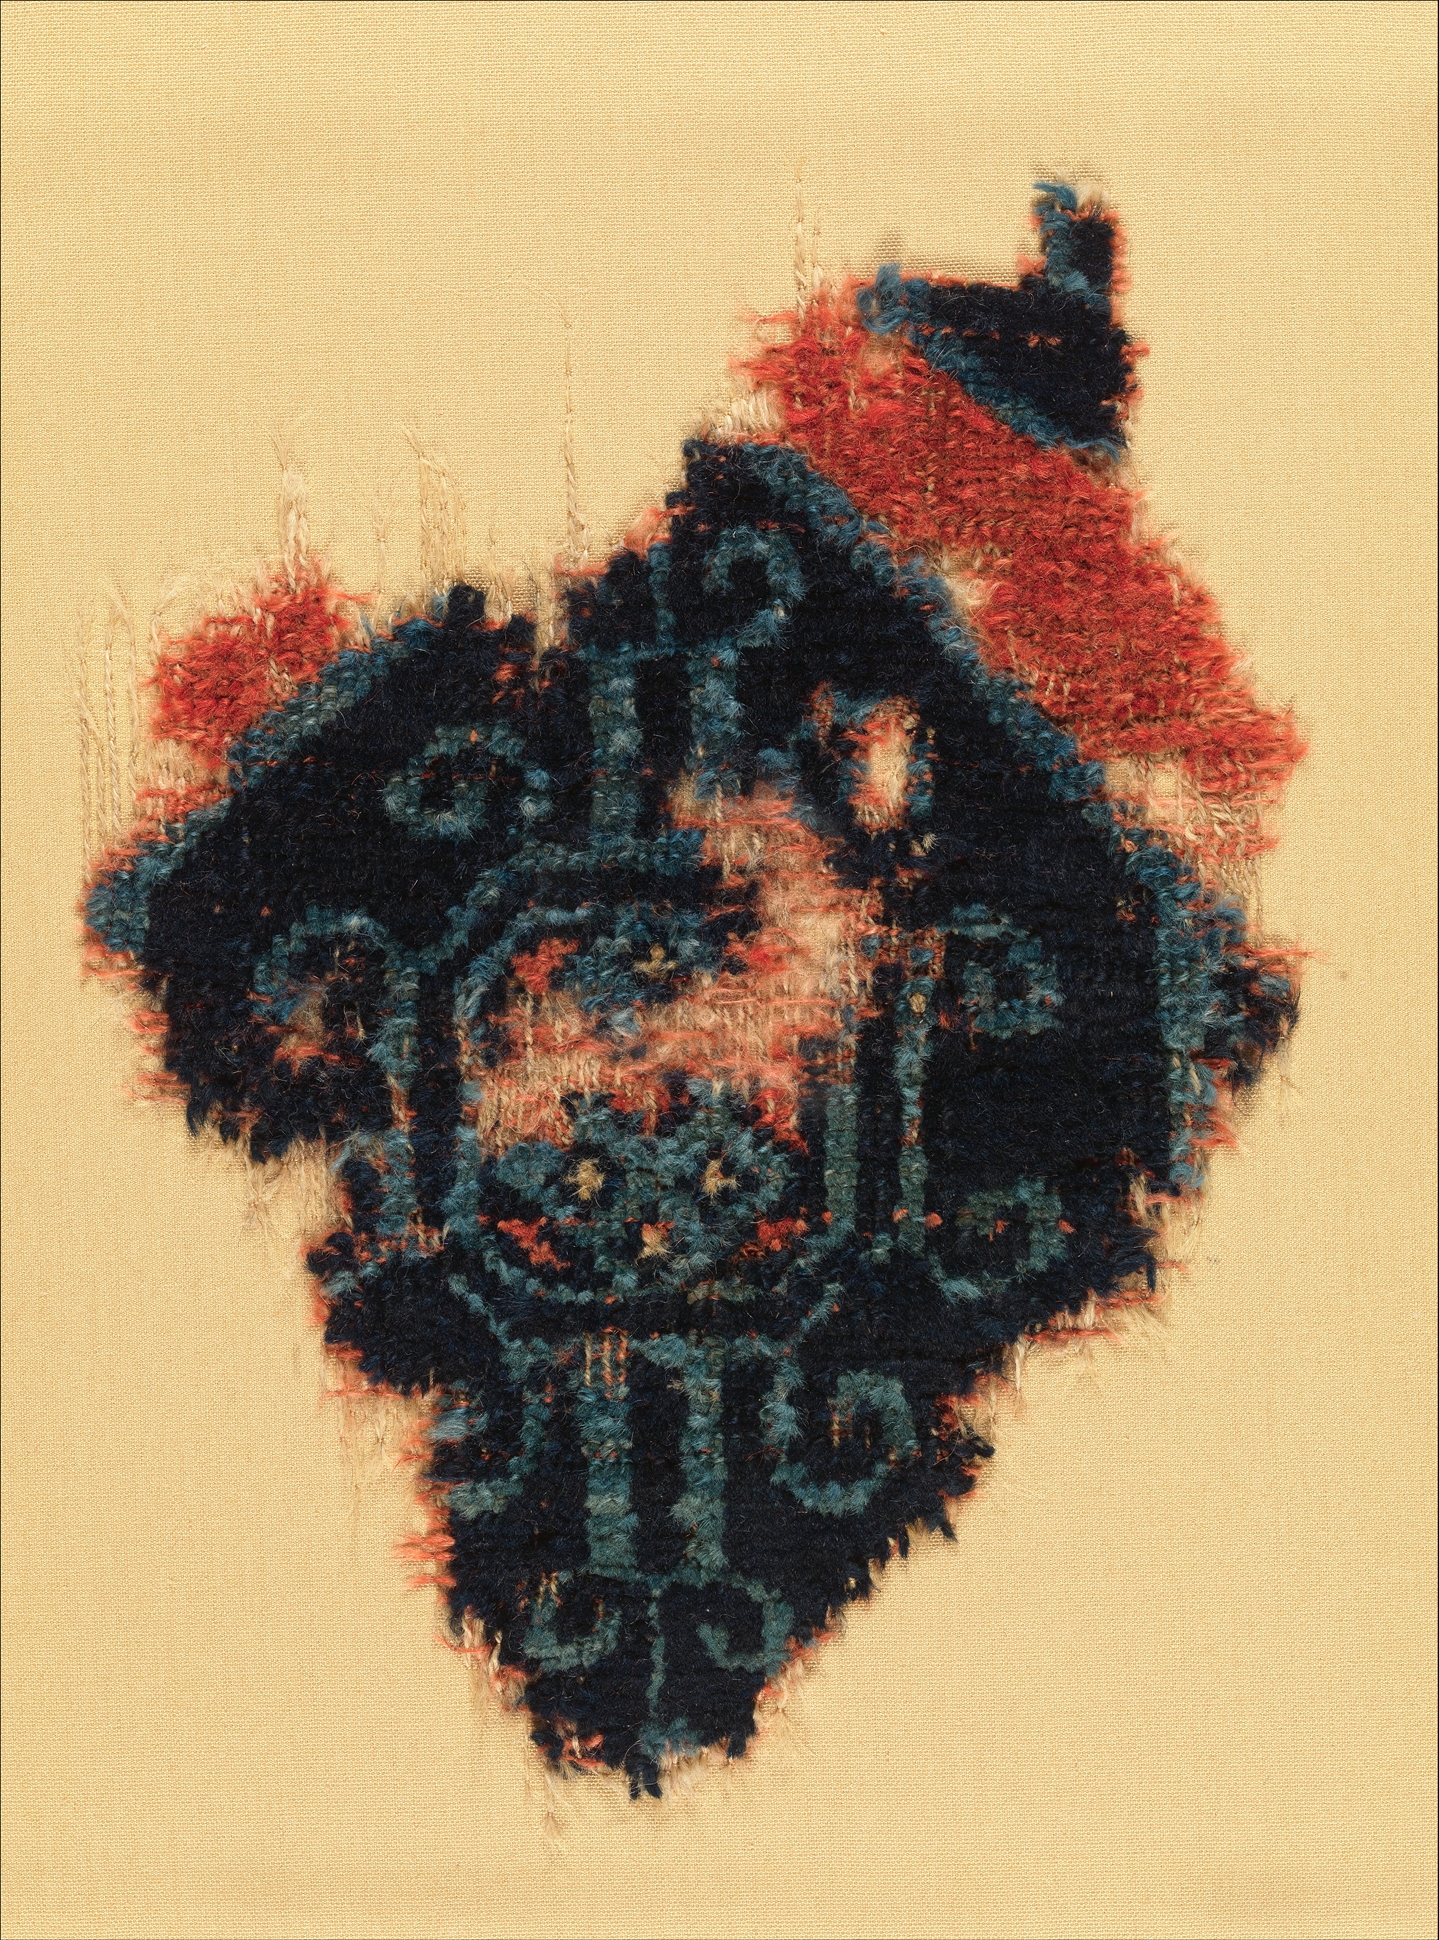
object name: carpet fragment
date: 1201-1333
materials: wool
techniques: pile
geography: turkey